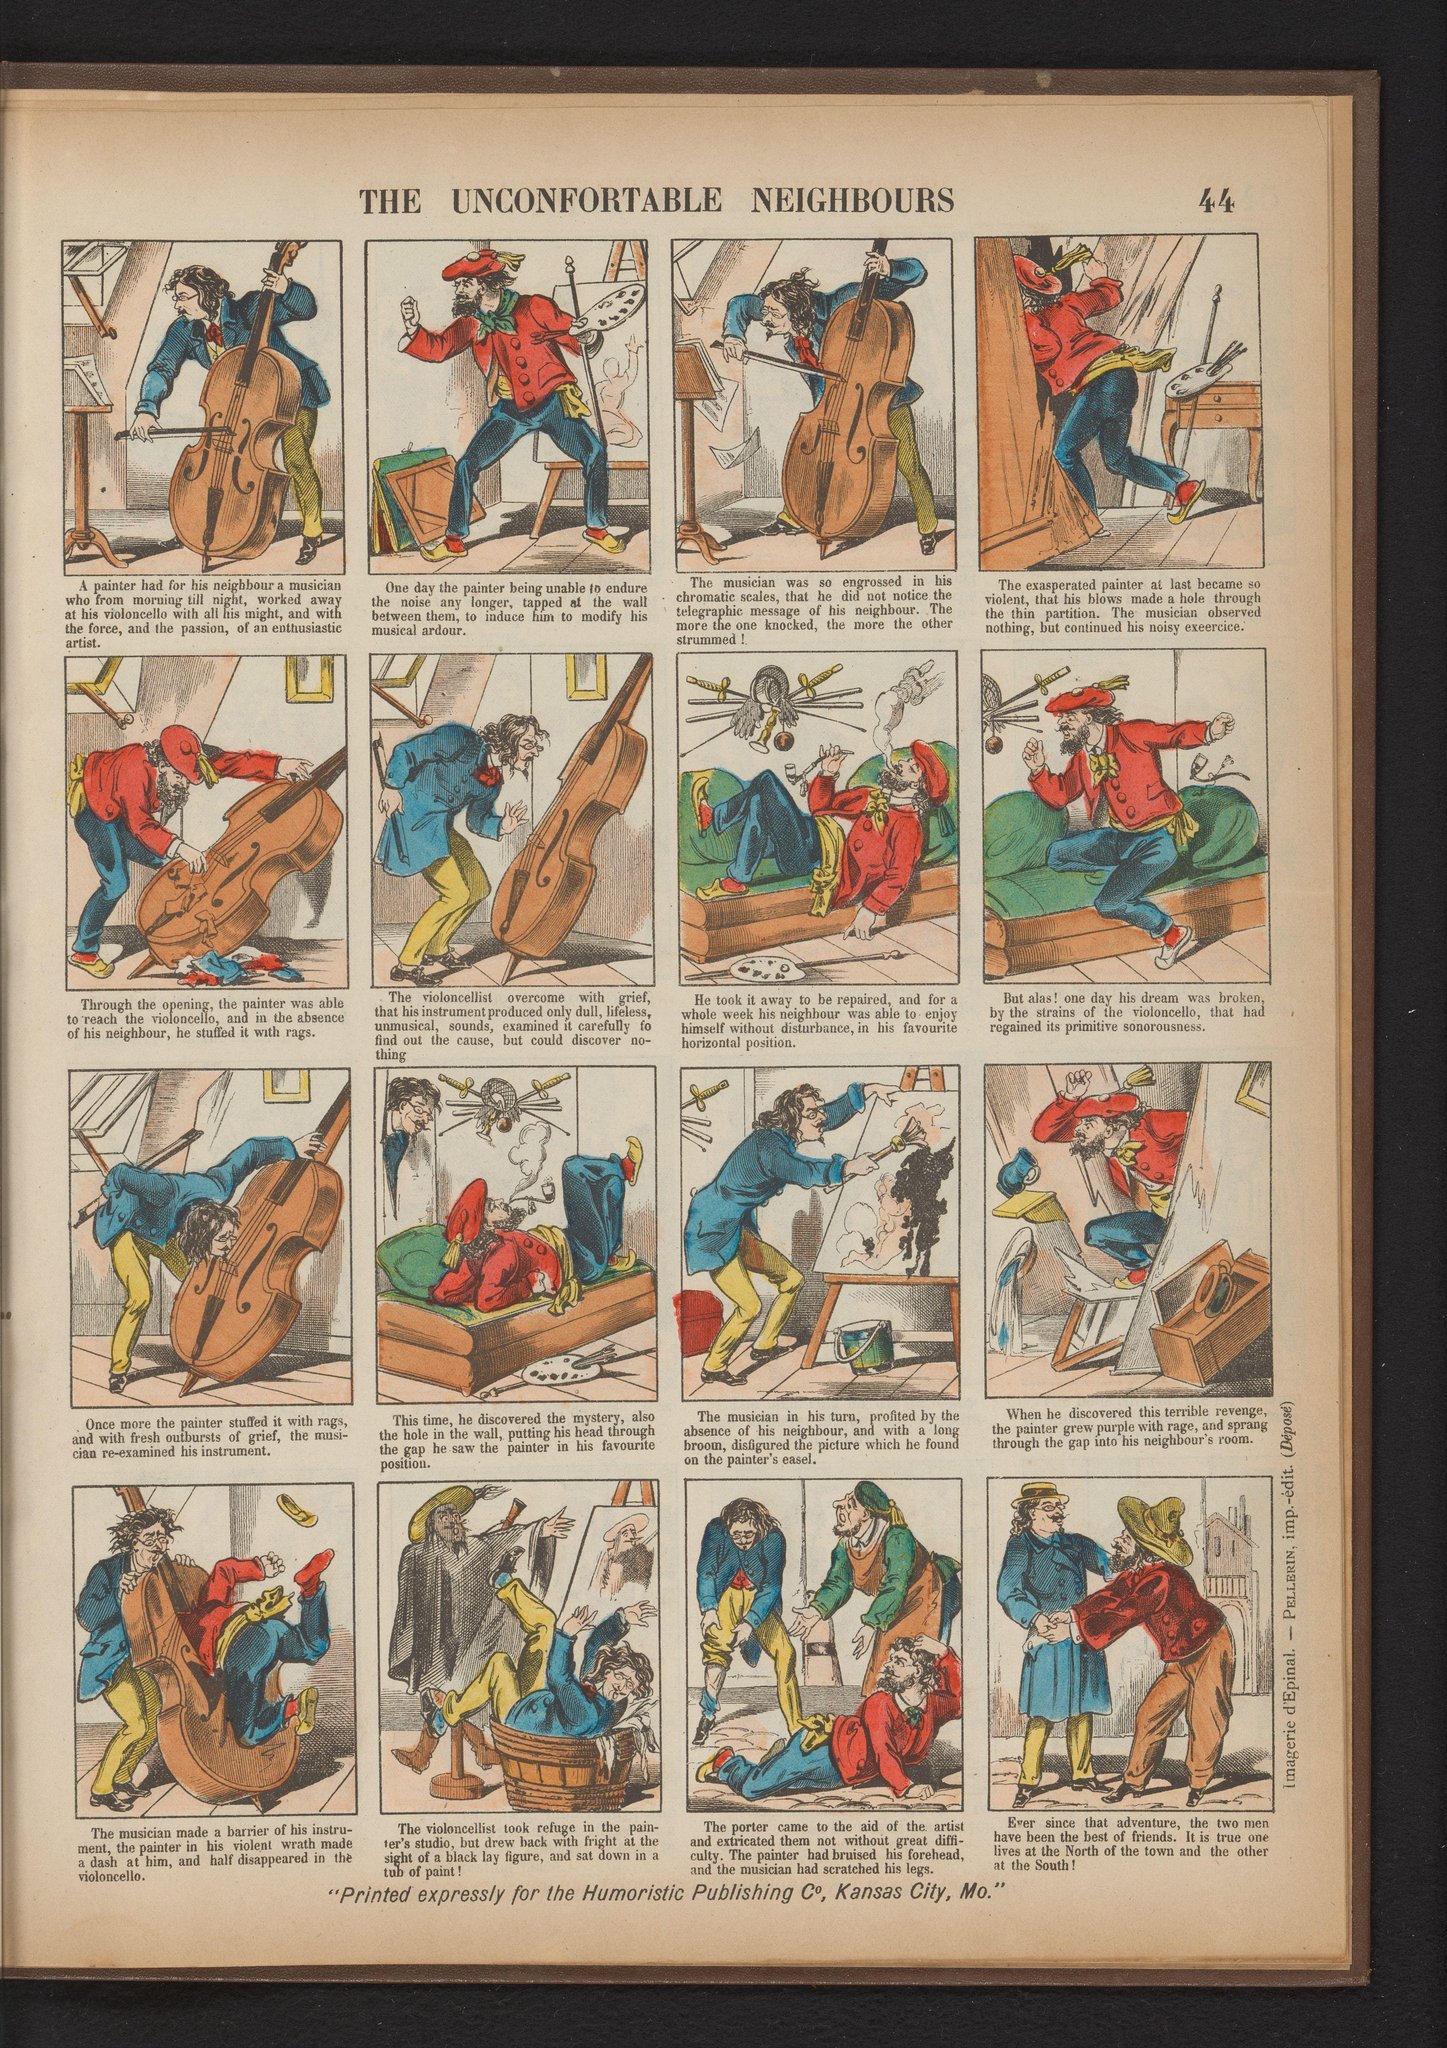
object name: print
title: The uncomfortable neighbours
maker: Anonymous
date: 1893-1894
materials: paper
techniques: colour, letterpress printing, lithograph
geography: kansas city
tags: literary characters and objects, viola, violoncello; double bass, painter at work, in his studio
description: Blad met zestien voorstellingen met het verhaal van een schilder en een cellist die buren zijn. Onder elke voorstelling een onderschrift in het Engels. Deze prent maakt deel uit van een album.